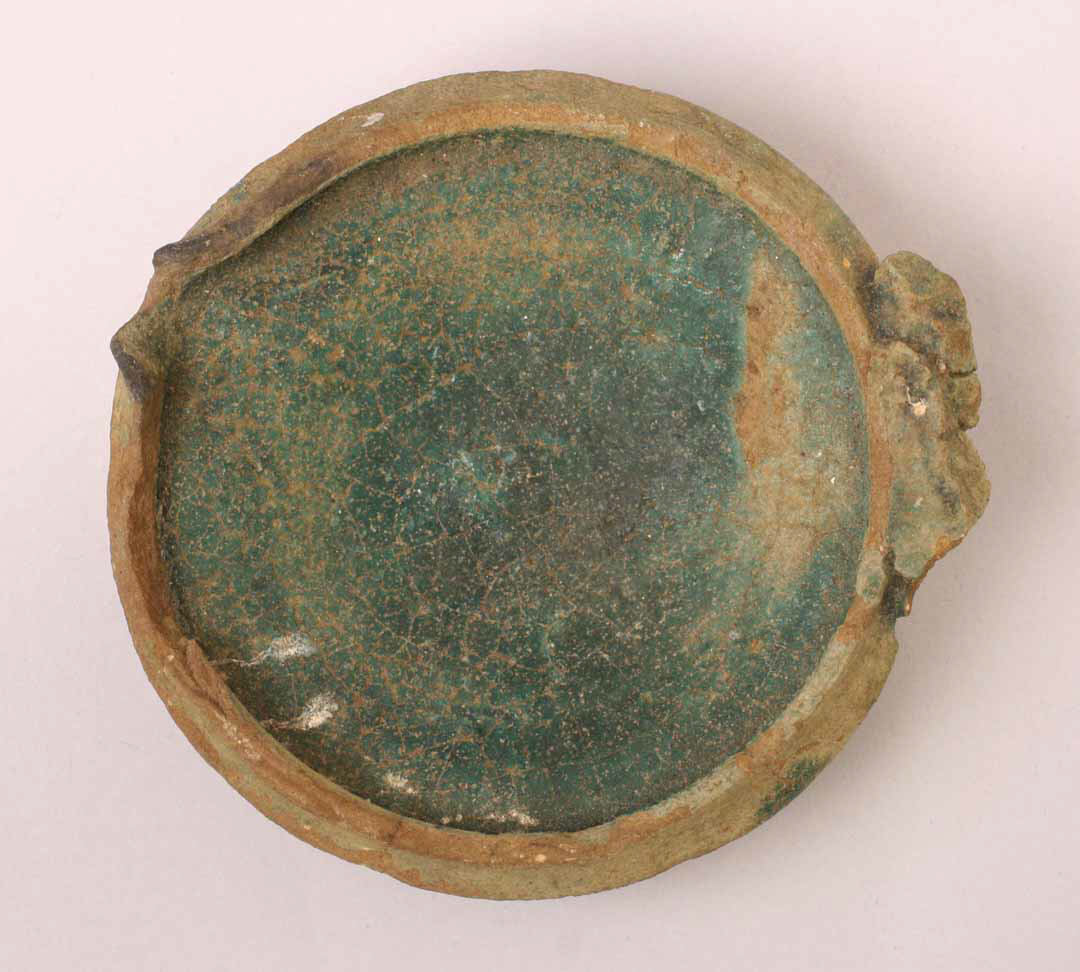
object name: oil lamp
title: Oil Lamp with Open Reservoir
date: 701-900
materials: earthenware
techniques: glazing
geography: iraq